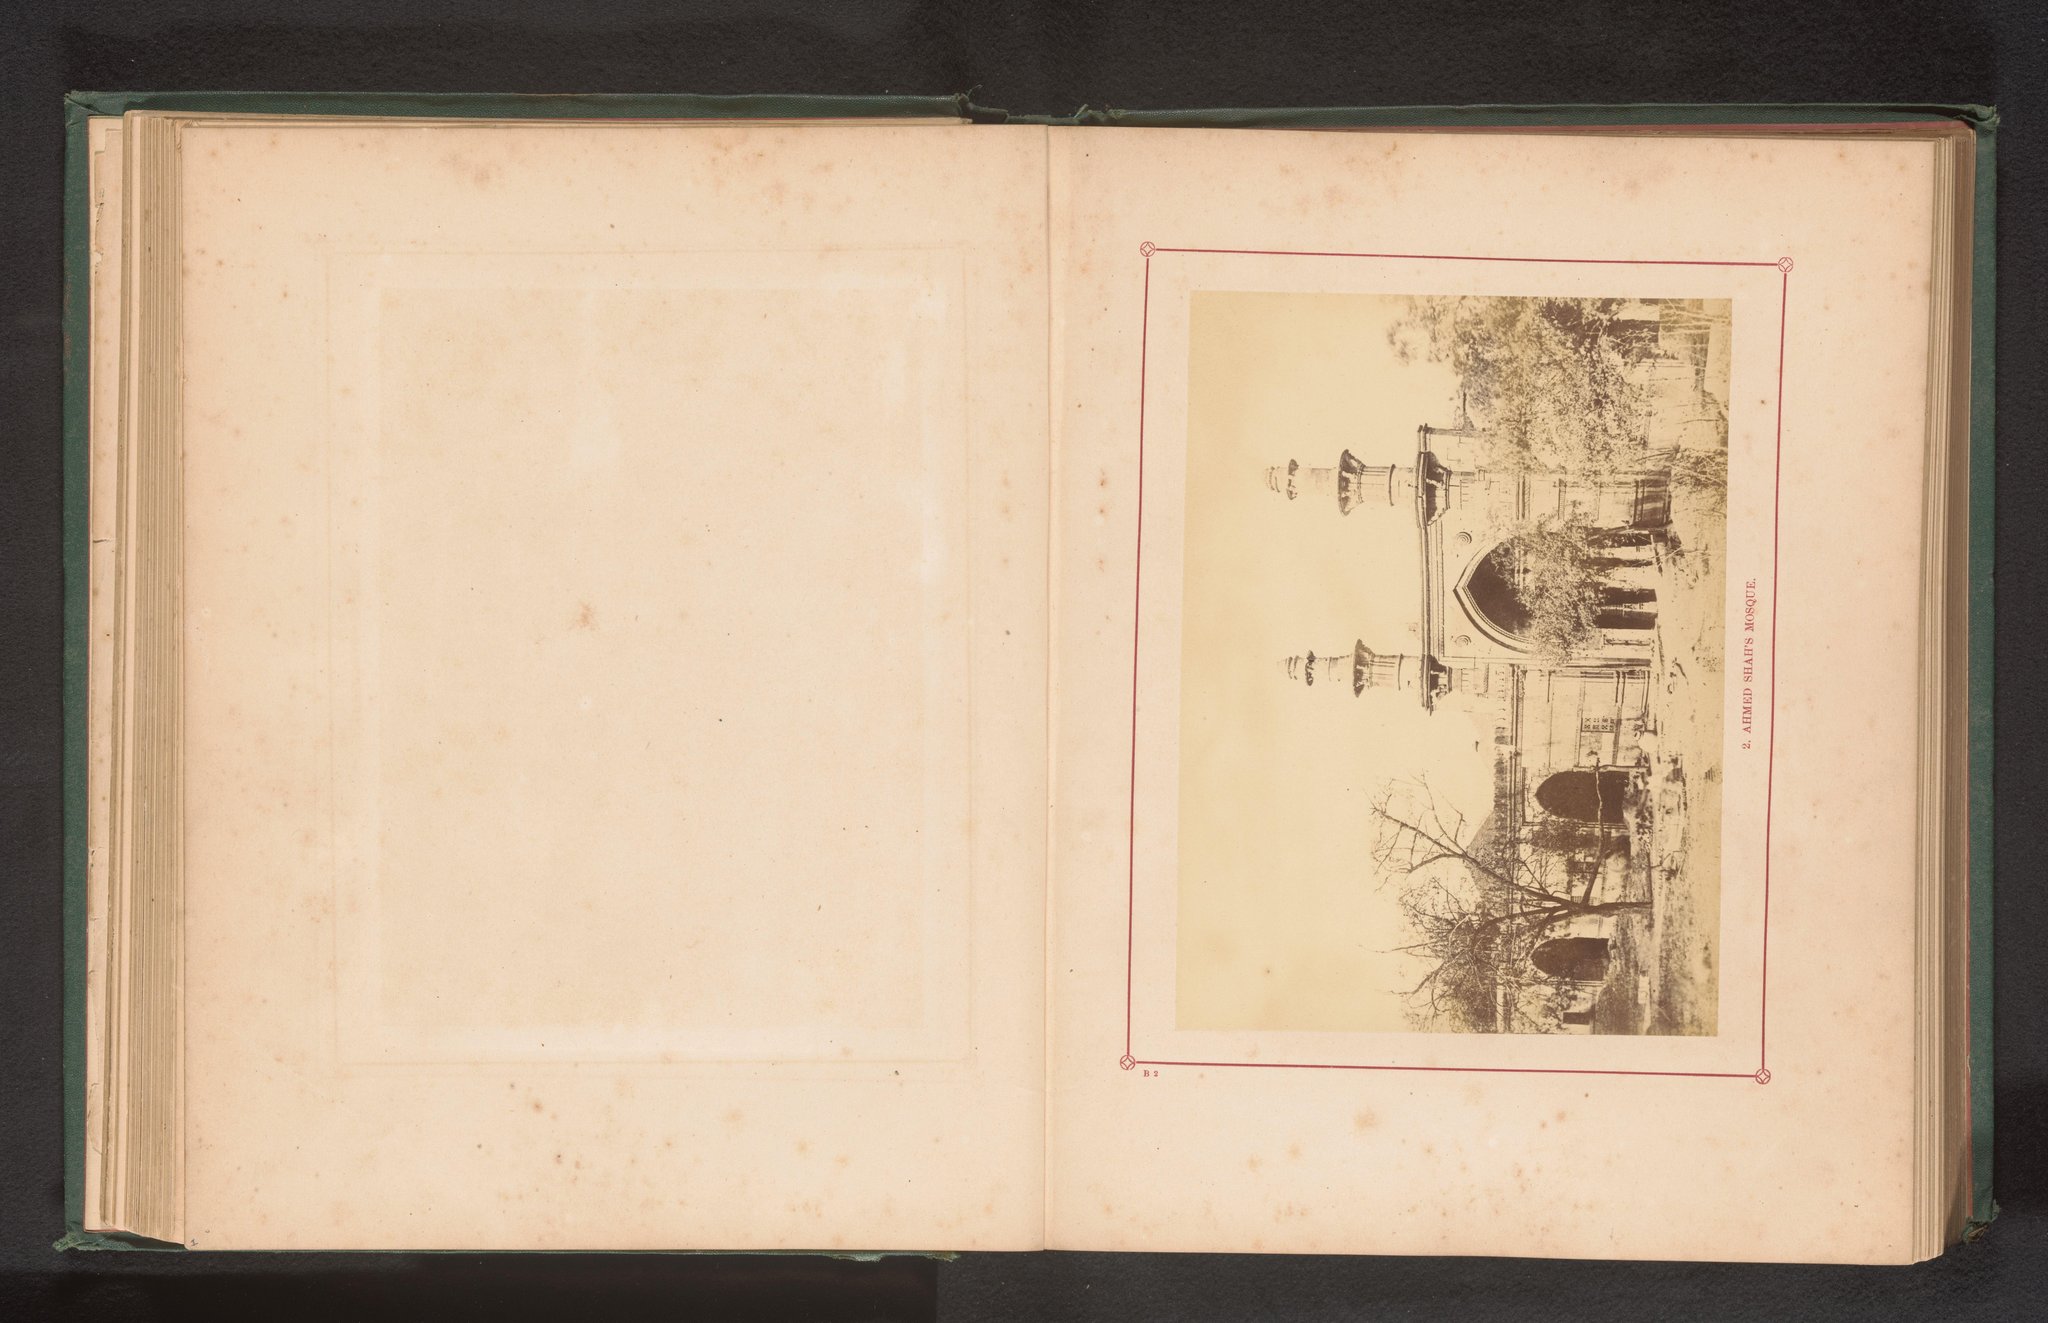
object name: page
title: Ahmed Shah's Mosque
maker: thomas biggs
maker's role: fotograaf, kapitein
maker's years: 1822-1905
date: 1856-1866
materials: photographic support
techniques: albumen print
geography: ahmedabad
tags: temple, shrine ~ islam, mohammedanism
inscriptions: number: ‘2.’